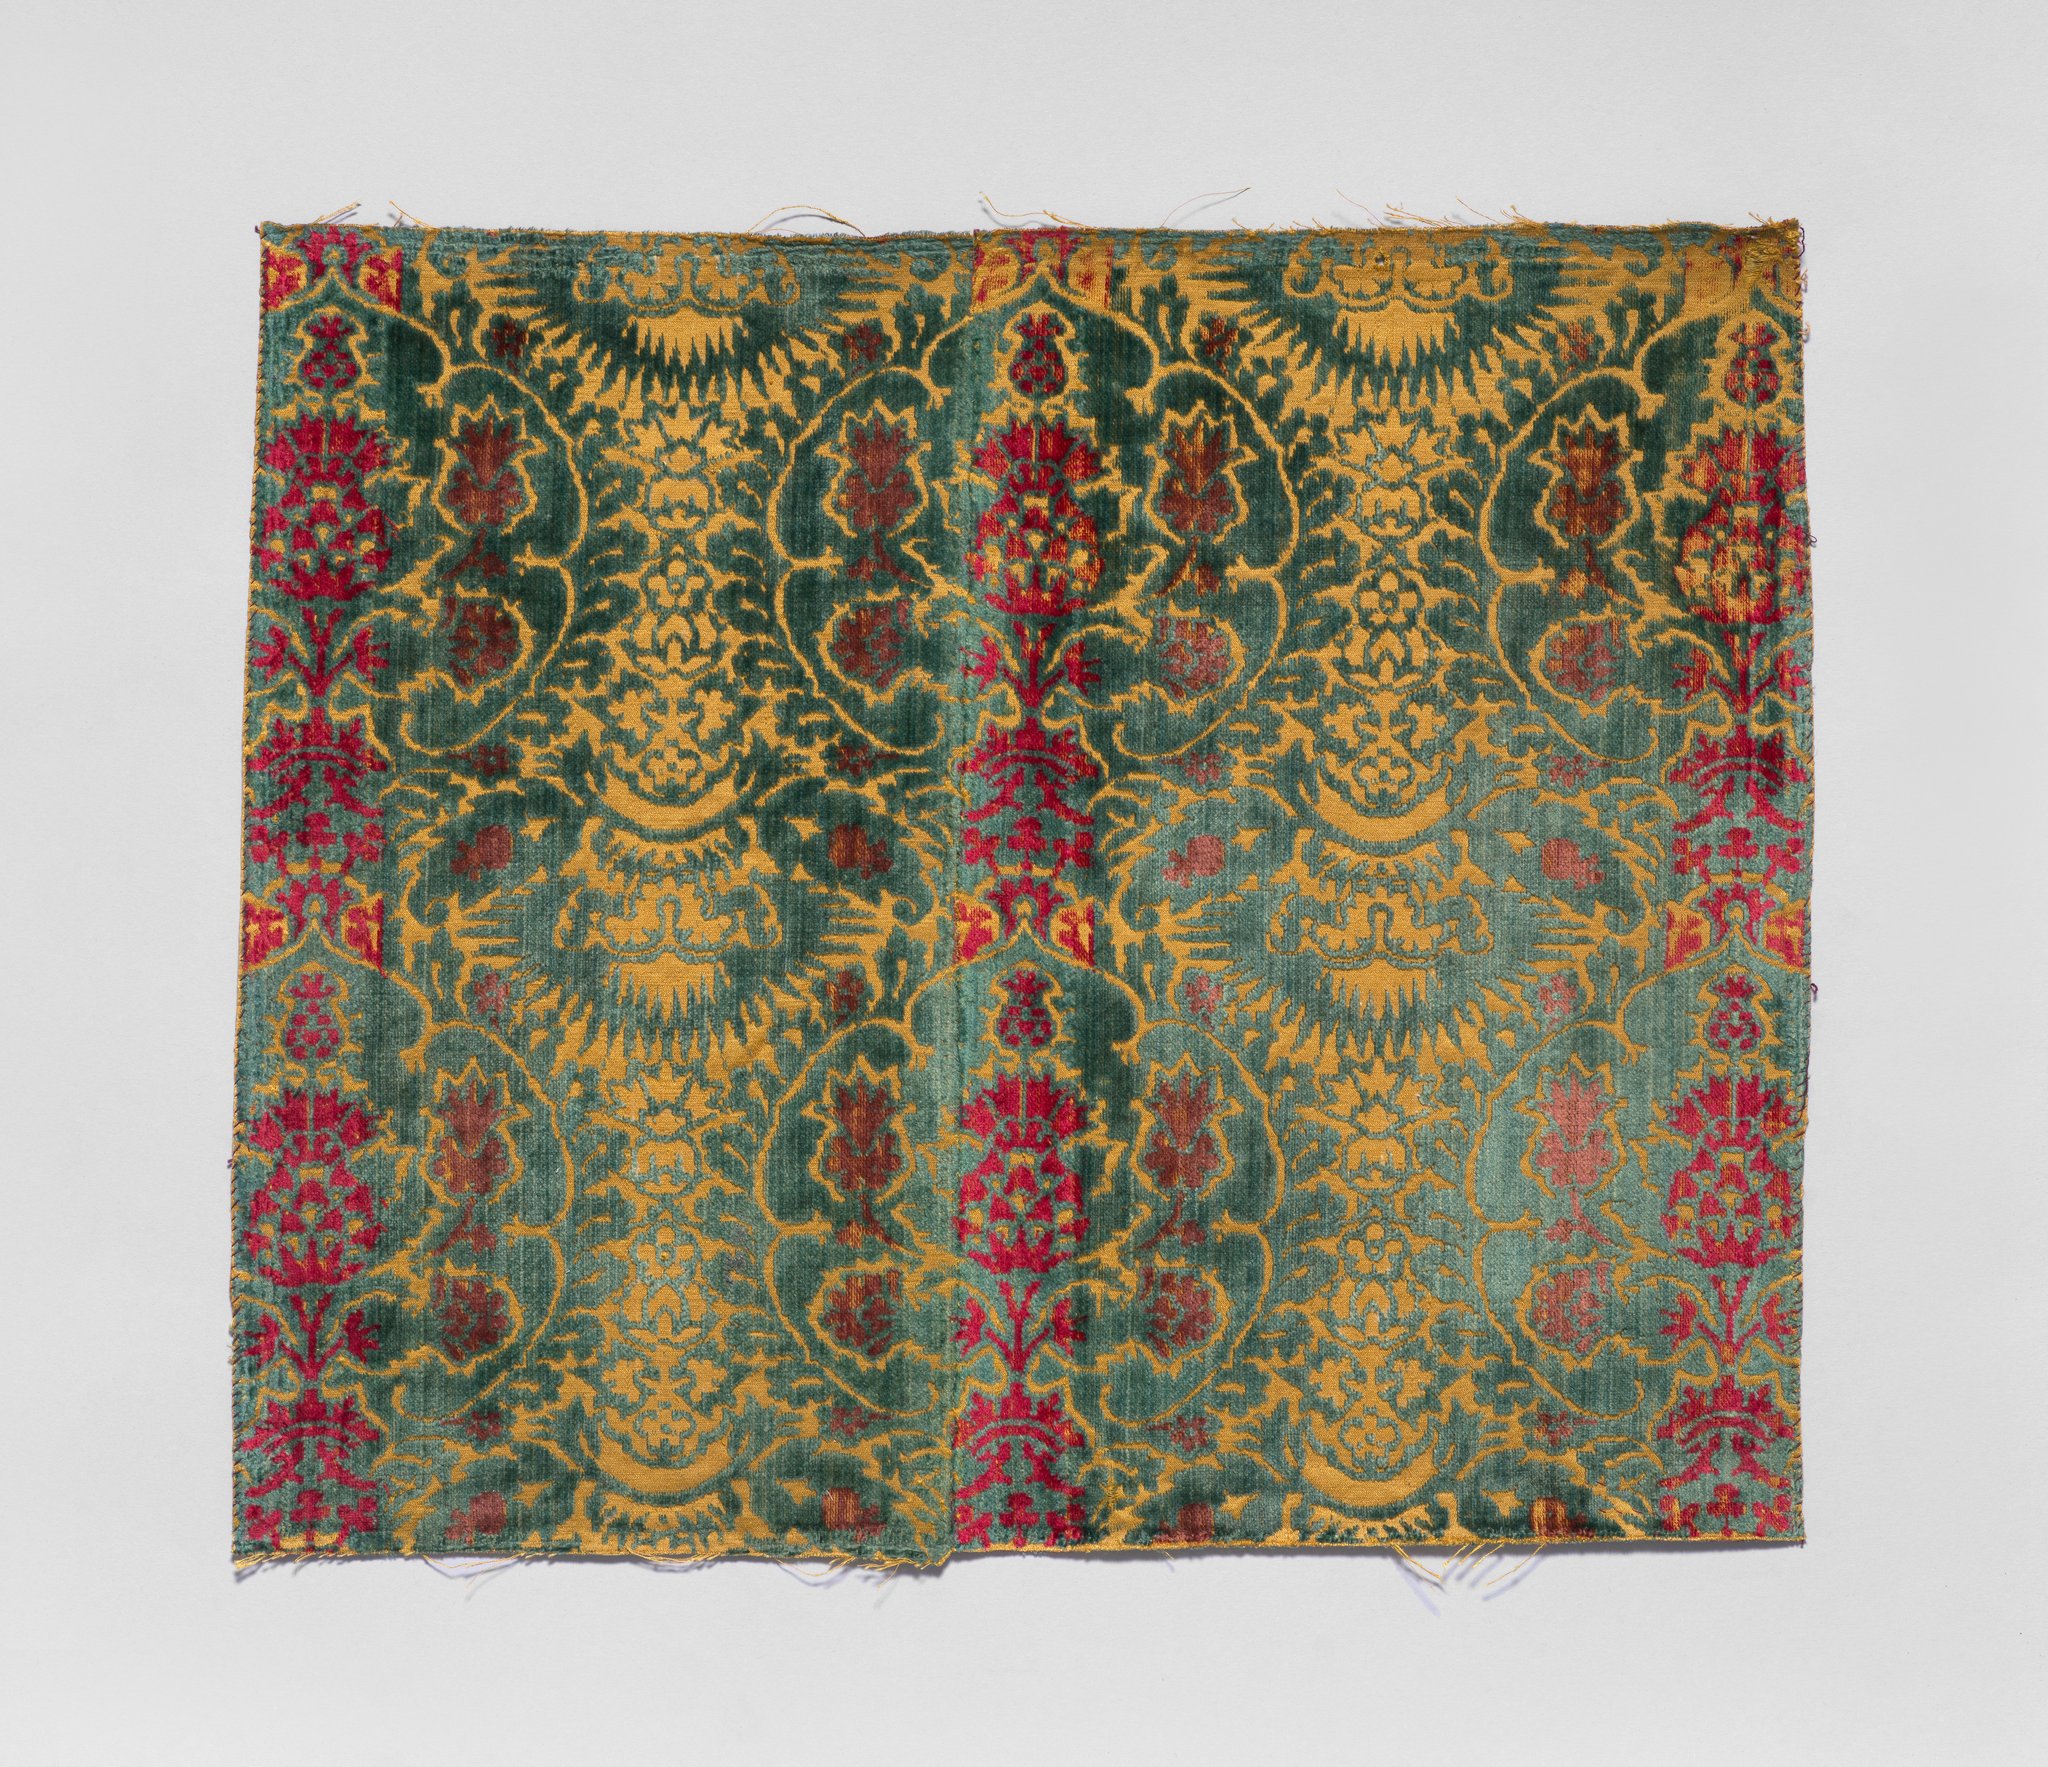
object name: piece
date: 1467-1500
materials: silk